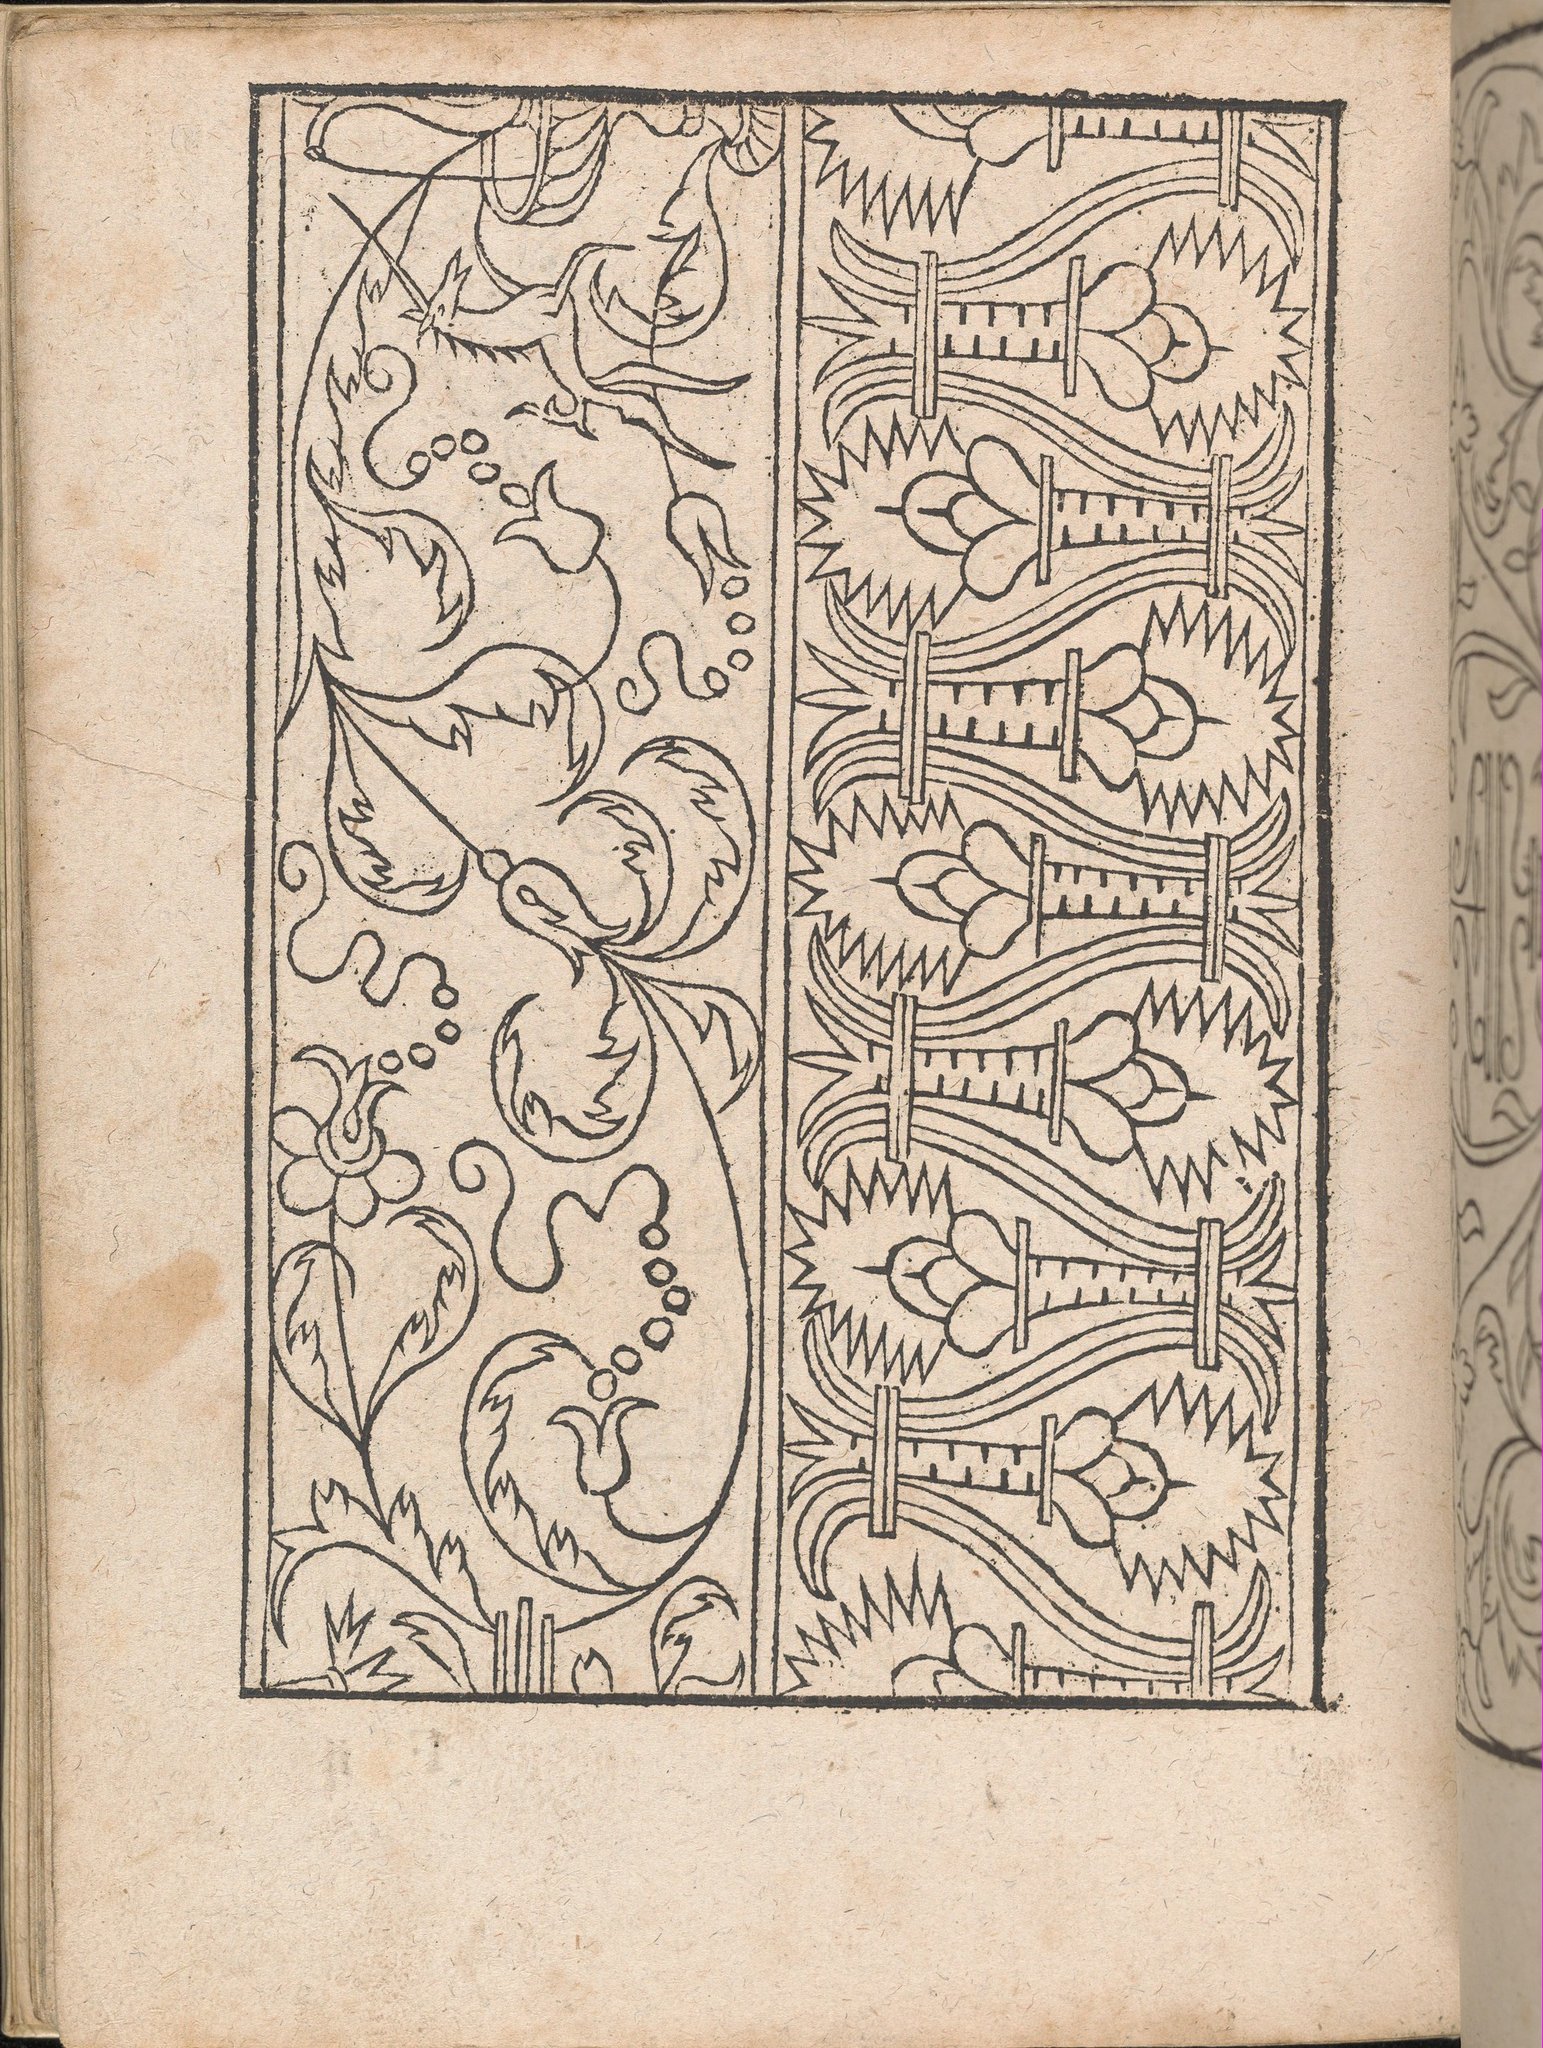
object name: book print ornament architecture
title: New Modelbüch allen Nägerin u. Sydenstickern (Page 22v)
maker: hans hoffman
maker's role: designer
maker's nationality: german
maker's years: 1556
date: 1556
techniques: woodcut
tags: ornament